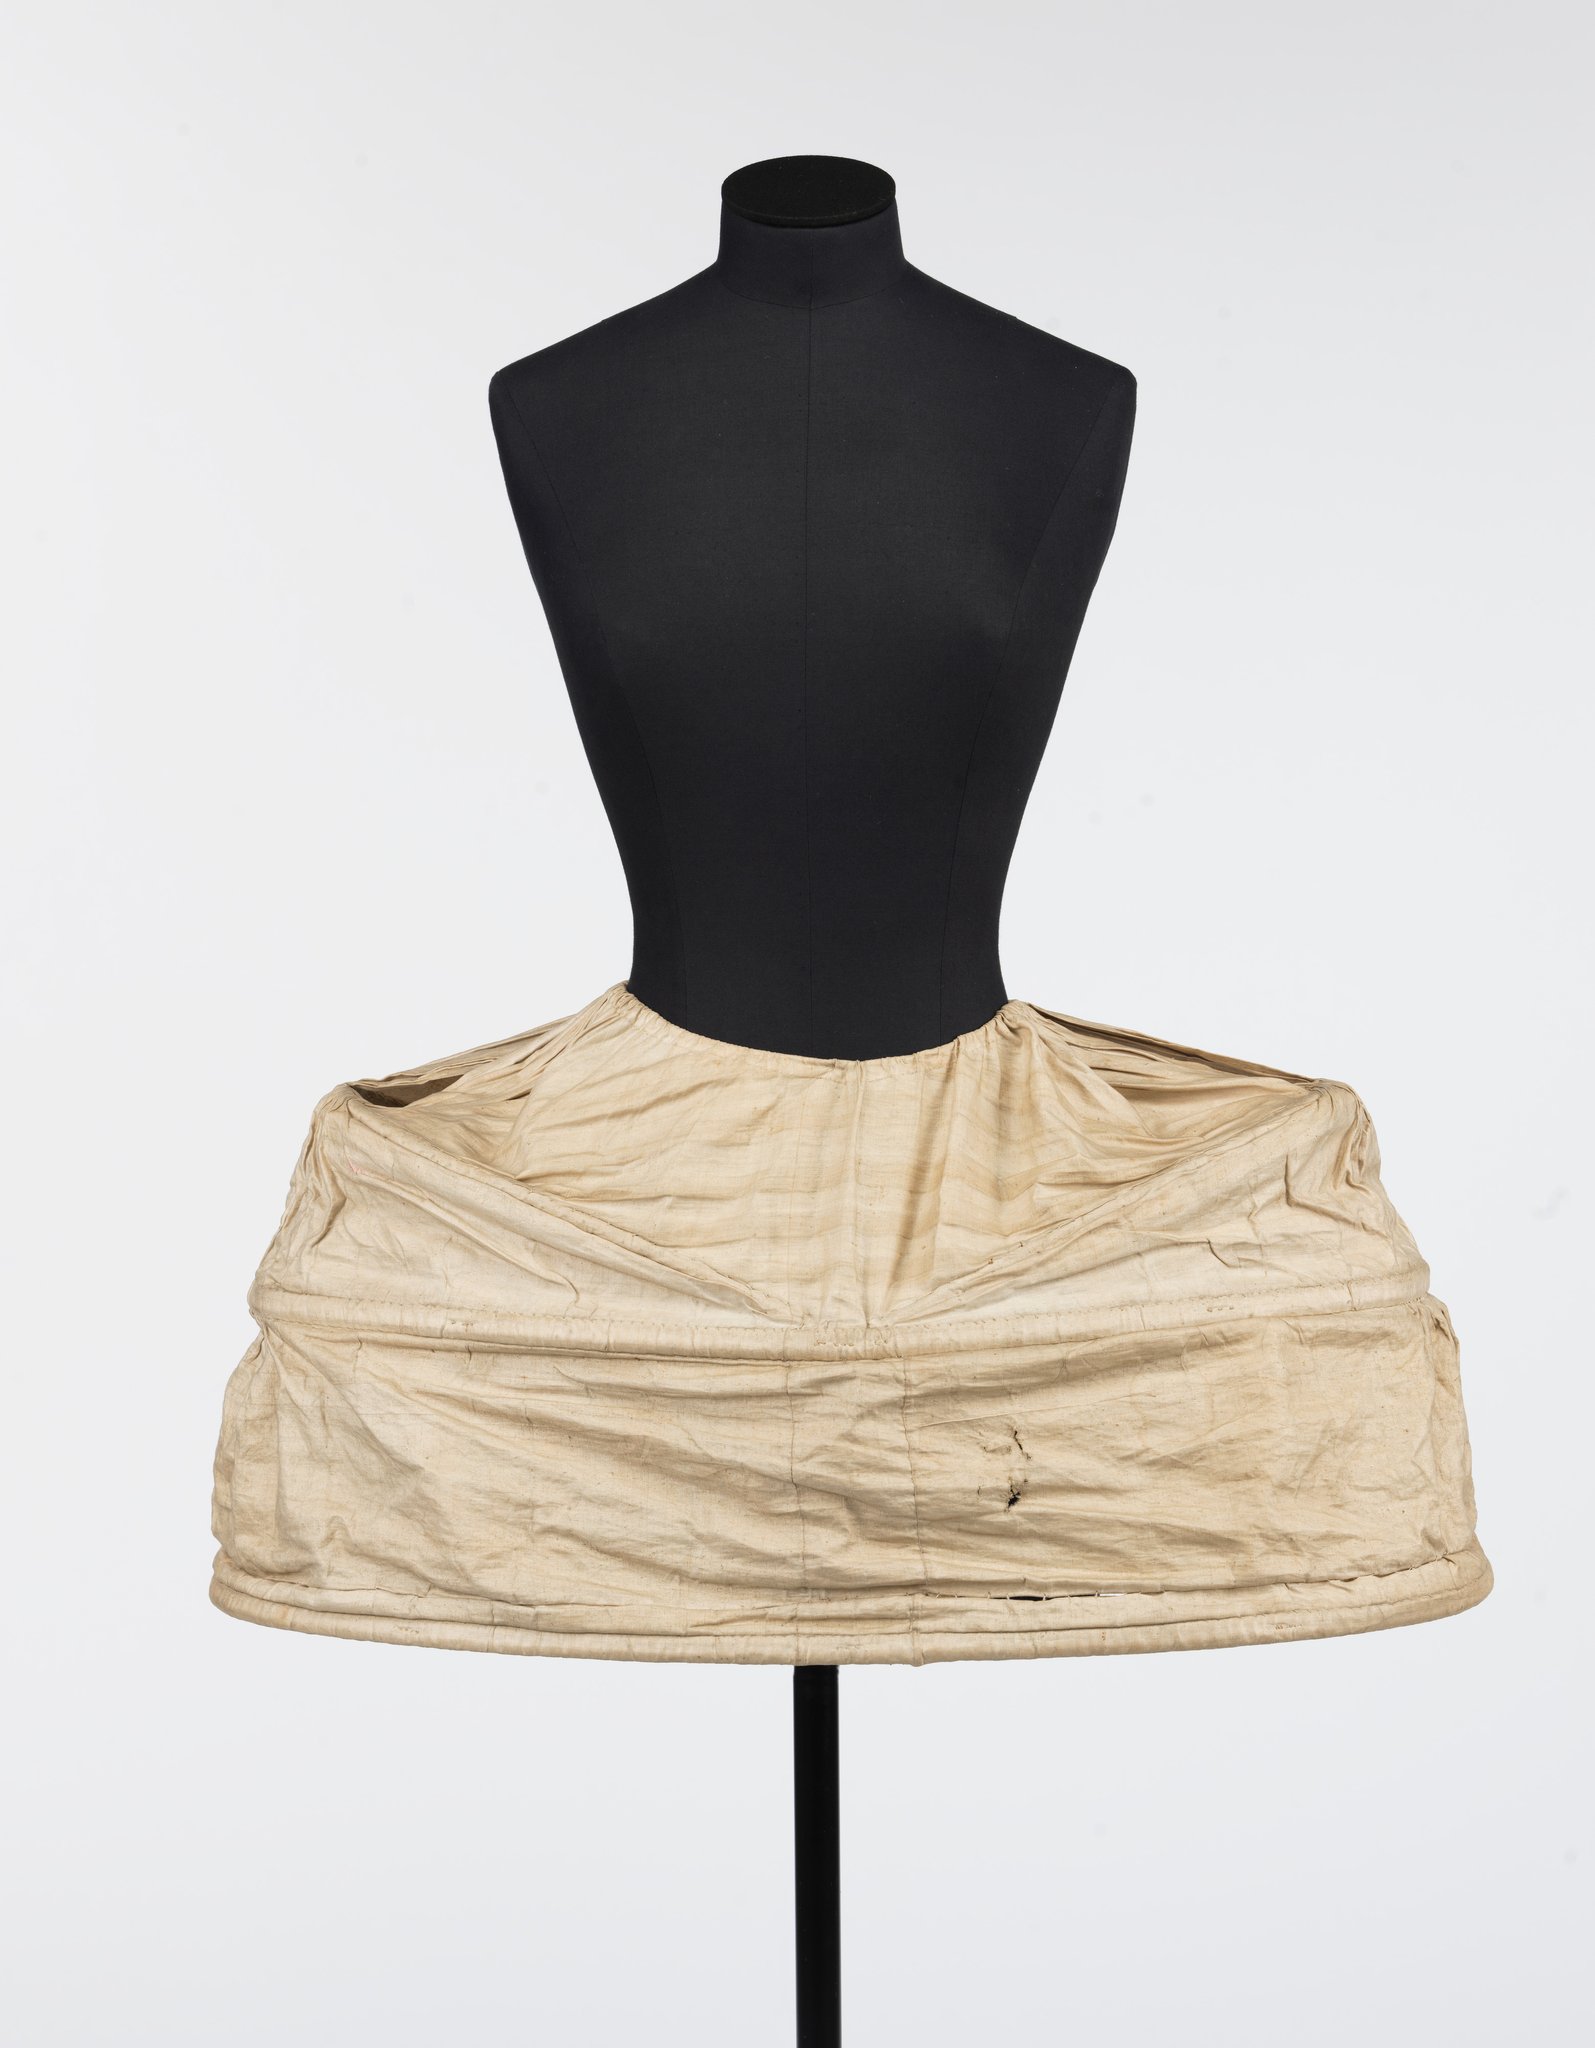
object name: hoop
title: Hoops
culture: british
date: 1770-1779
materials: linen